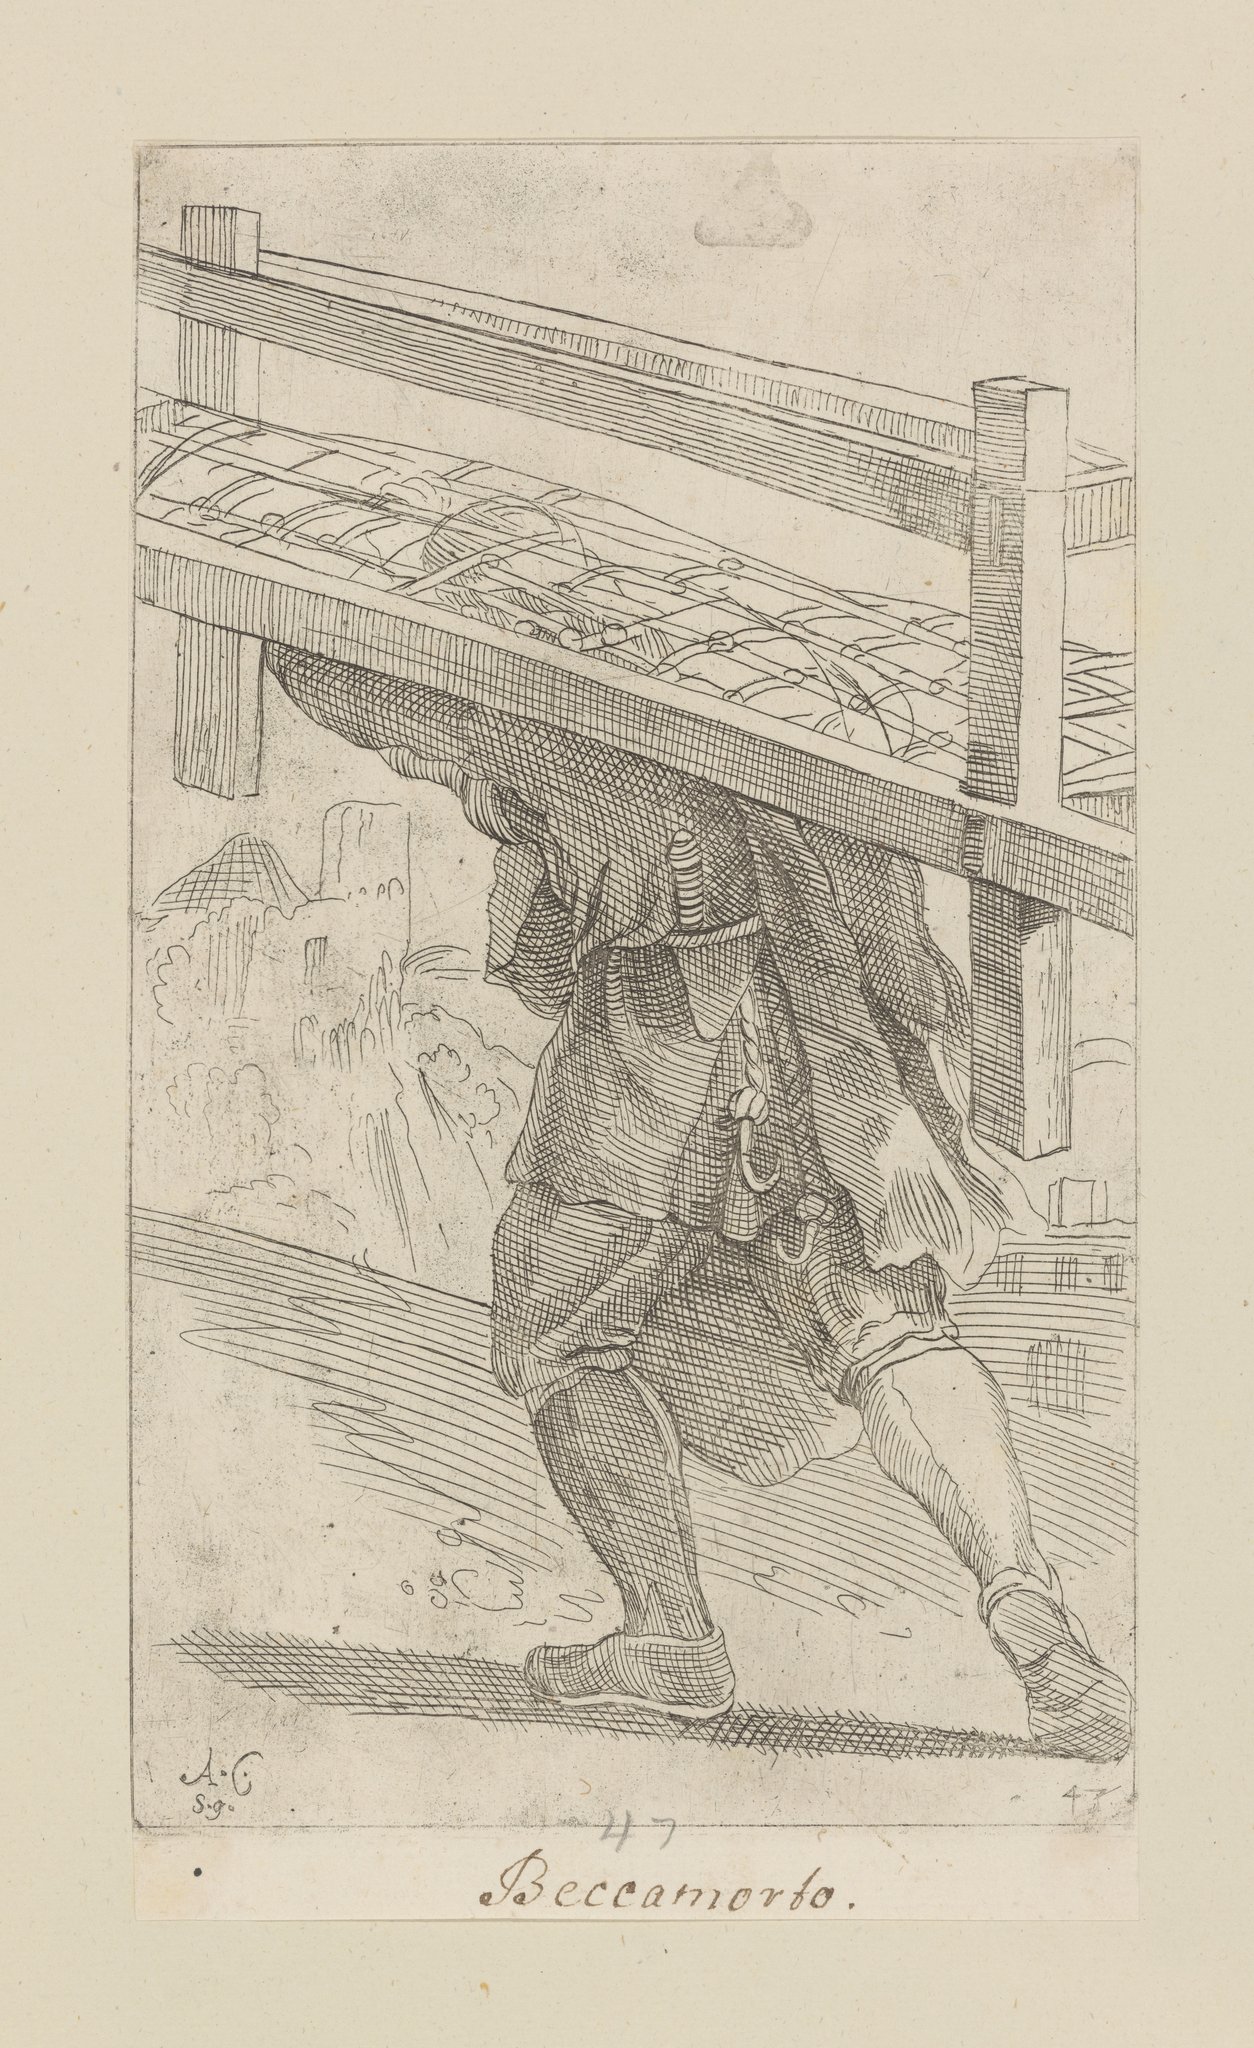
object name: print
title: Plate 43: Casket carrier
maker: simon guillain ii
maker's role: artist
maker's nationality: french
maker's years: 1618-1718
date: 1646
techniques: etching